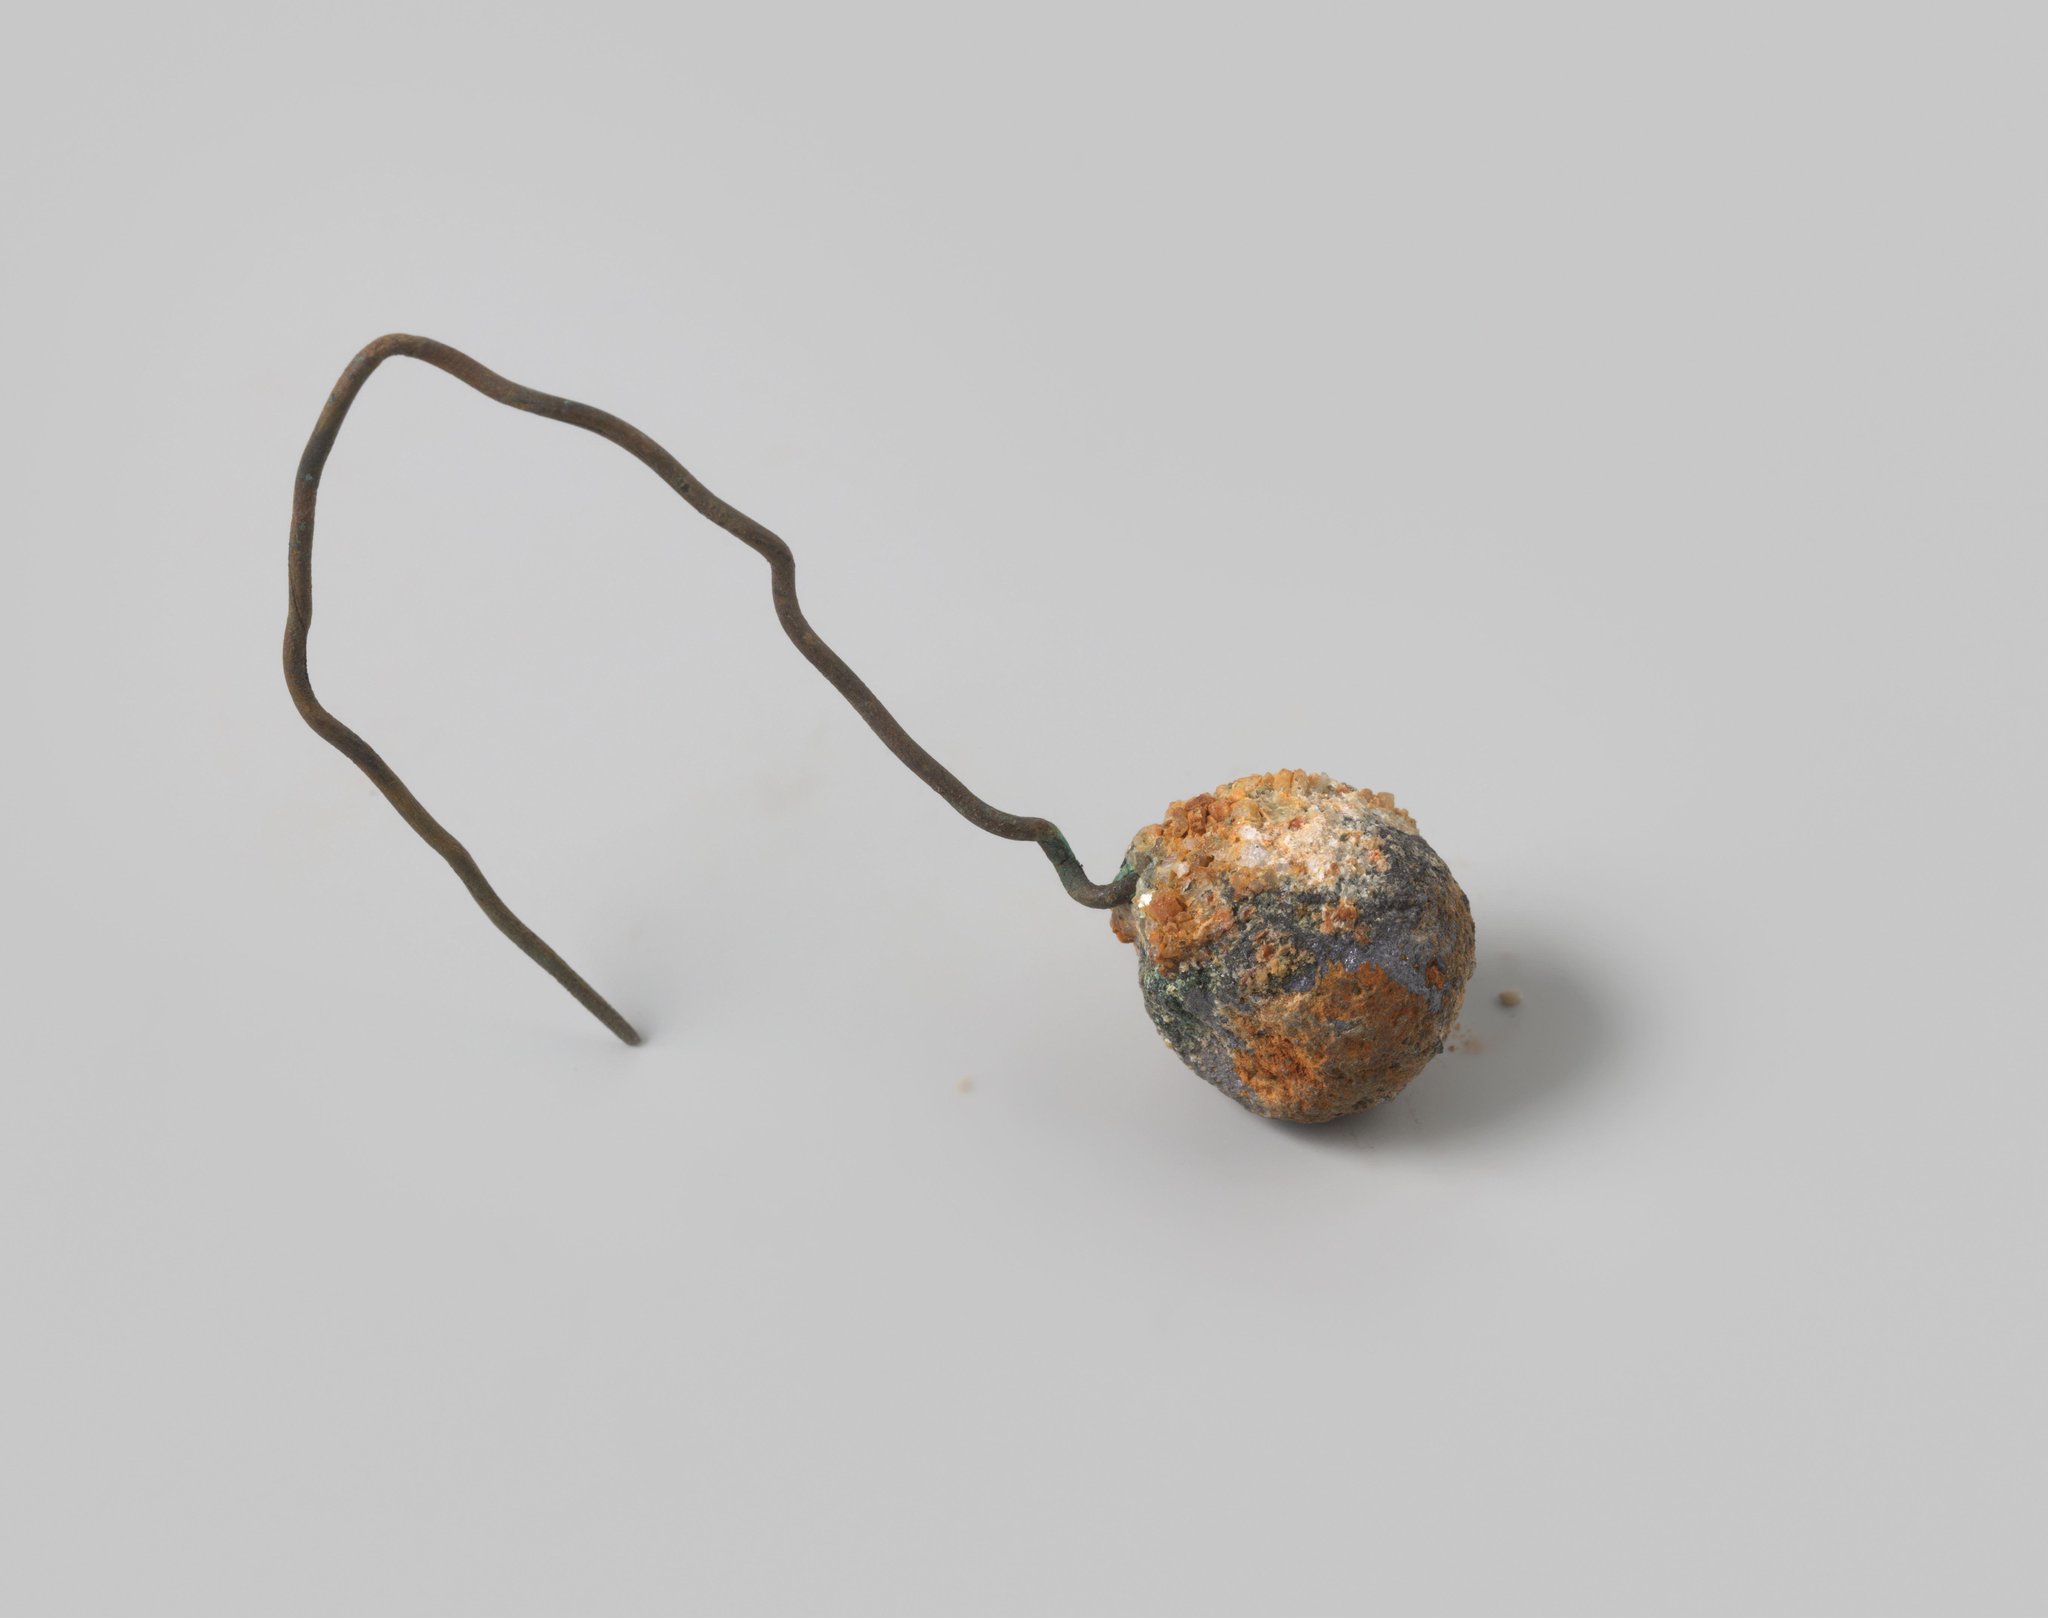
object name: chain shot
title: Kettingkogel uit het wrak van de Oost-Indiëvaarder Hollandia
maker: Anonymous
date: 1700-1743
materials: lead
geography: netherlands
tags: verenigde oostindische compagnie, hollandia (schip), annet